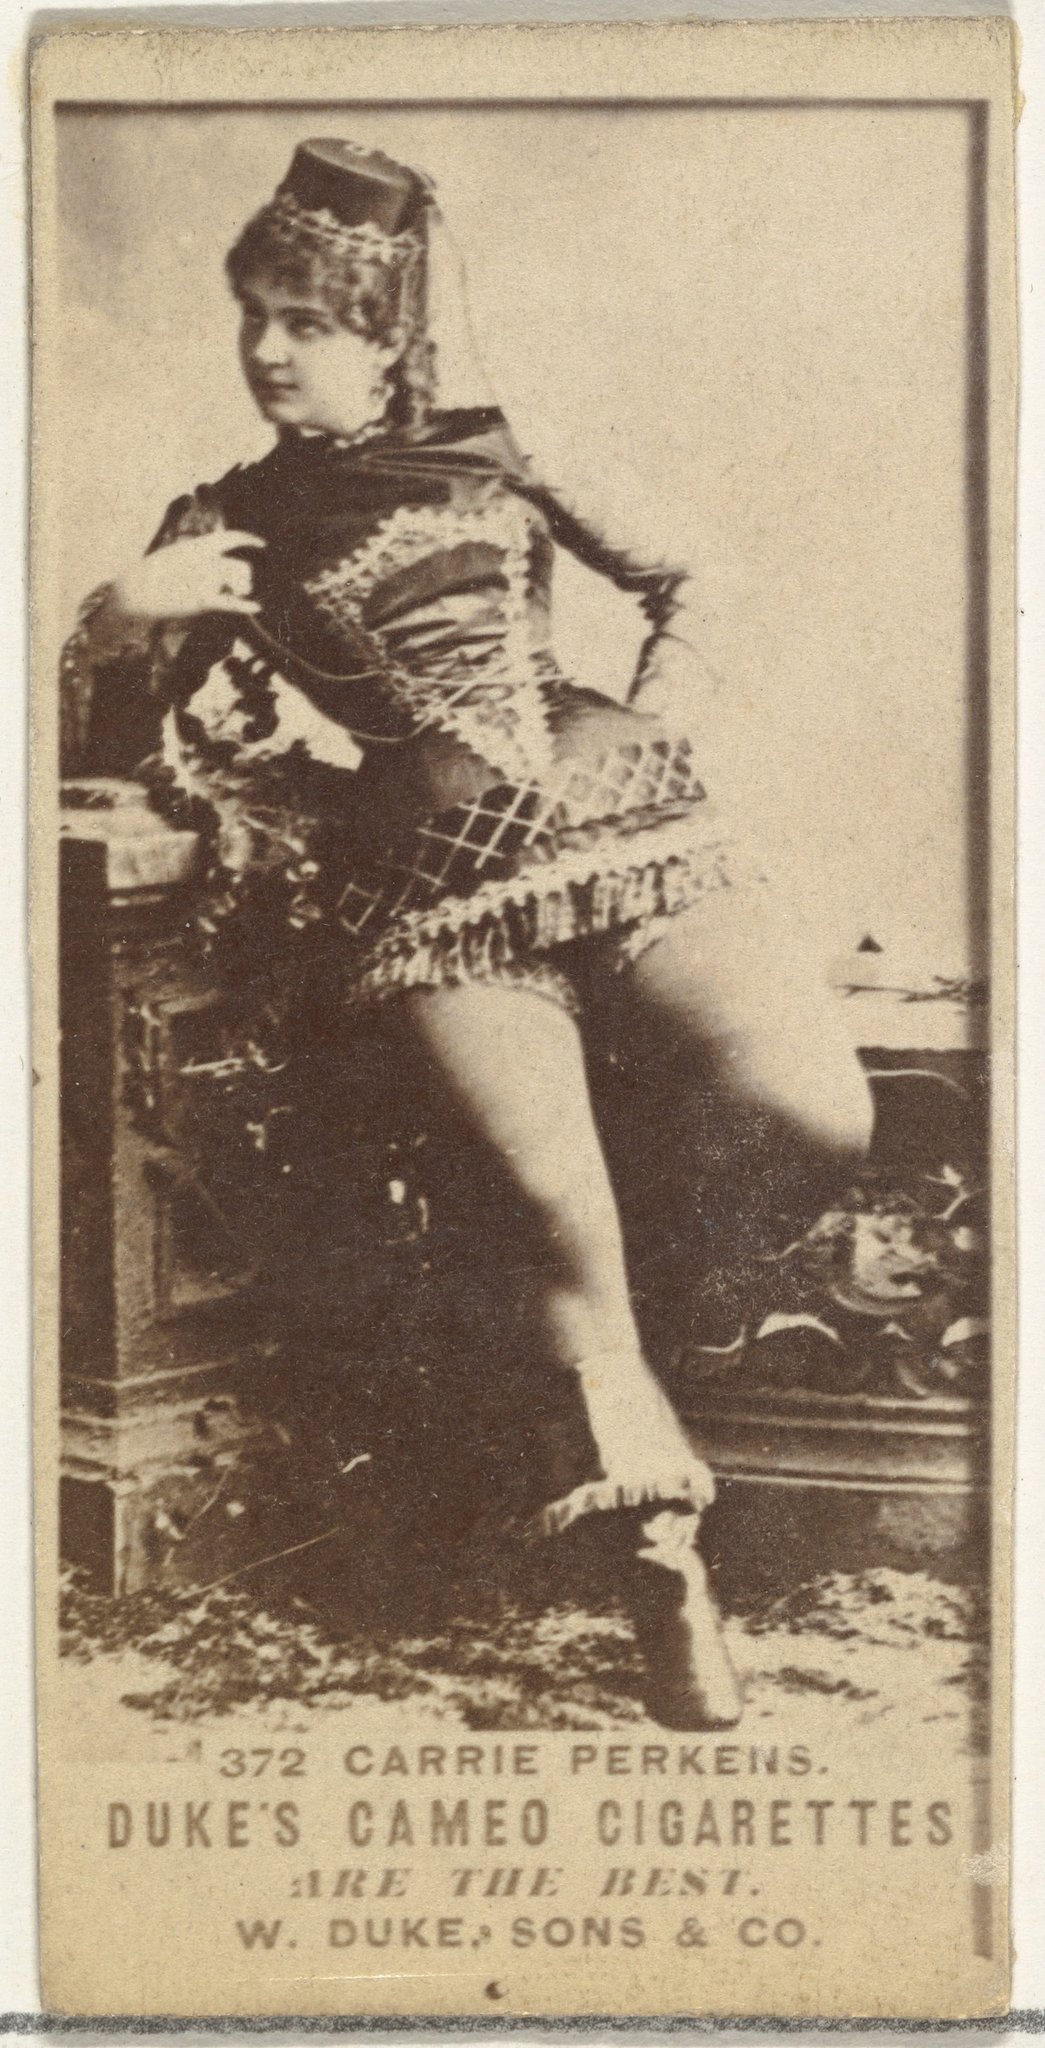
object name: photograph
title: Card Number 372, Carrie Perkens, from the Actors and Actresses series (N145-5) issued by Duke Sons & Co. to promote Cameo Cigarettes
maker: w. duke, sons & co.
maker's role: publisher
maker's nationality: american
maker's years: 1870-1920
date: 1880-1889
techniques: albumen silver print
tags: portraits,women,actresses